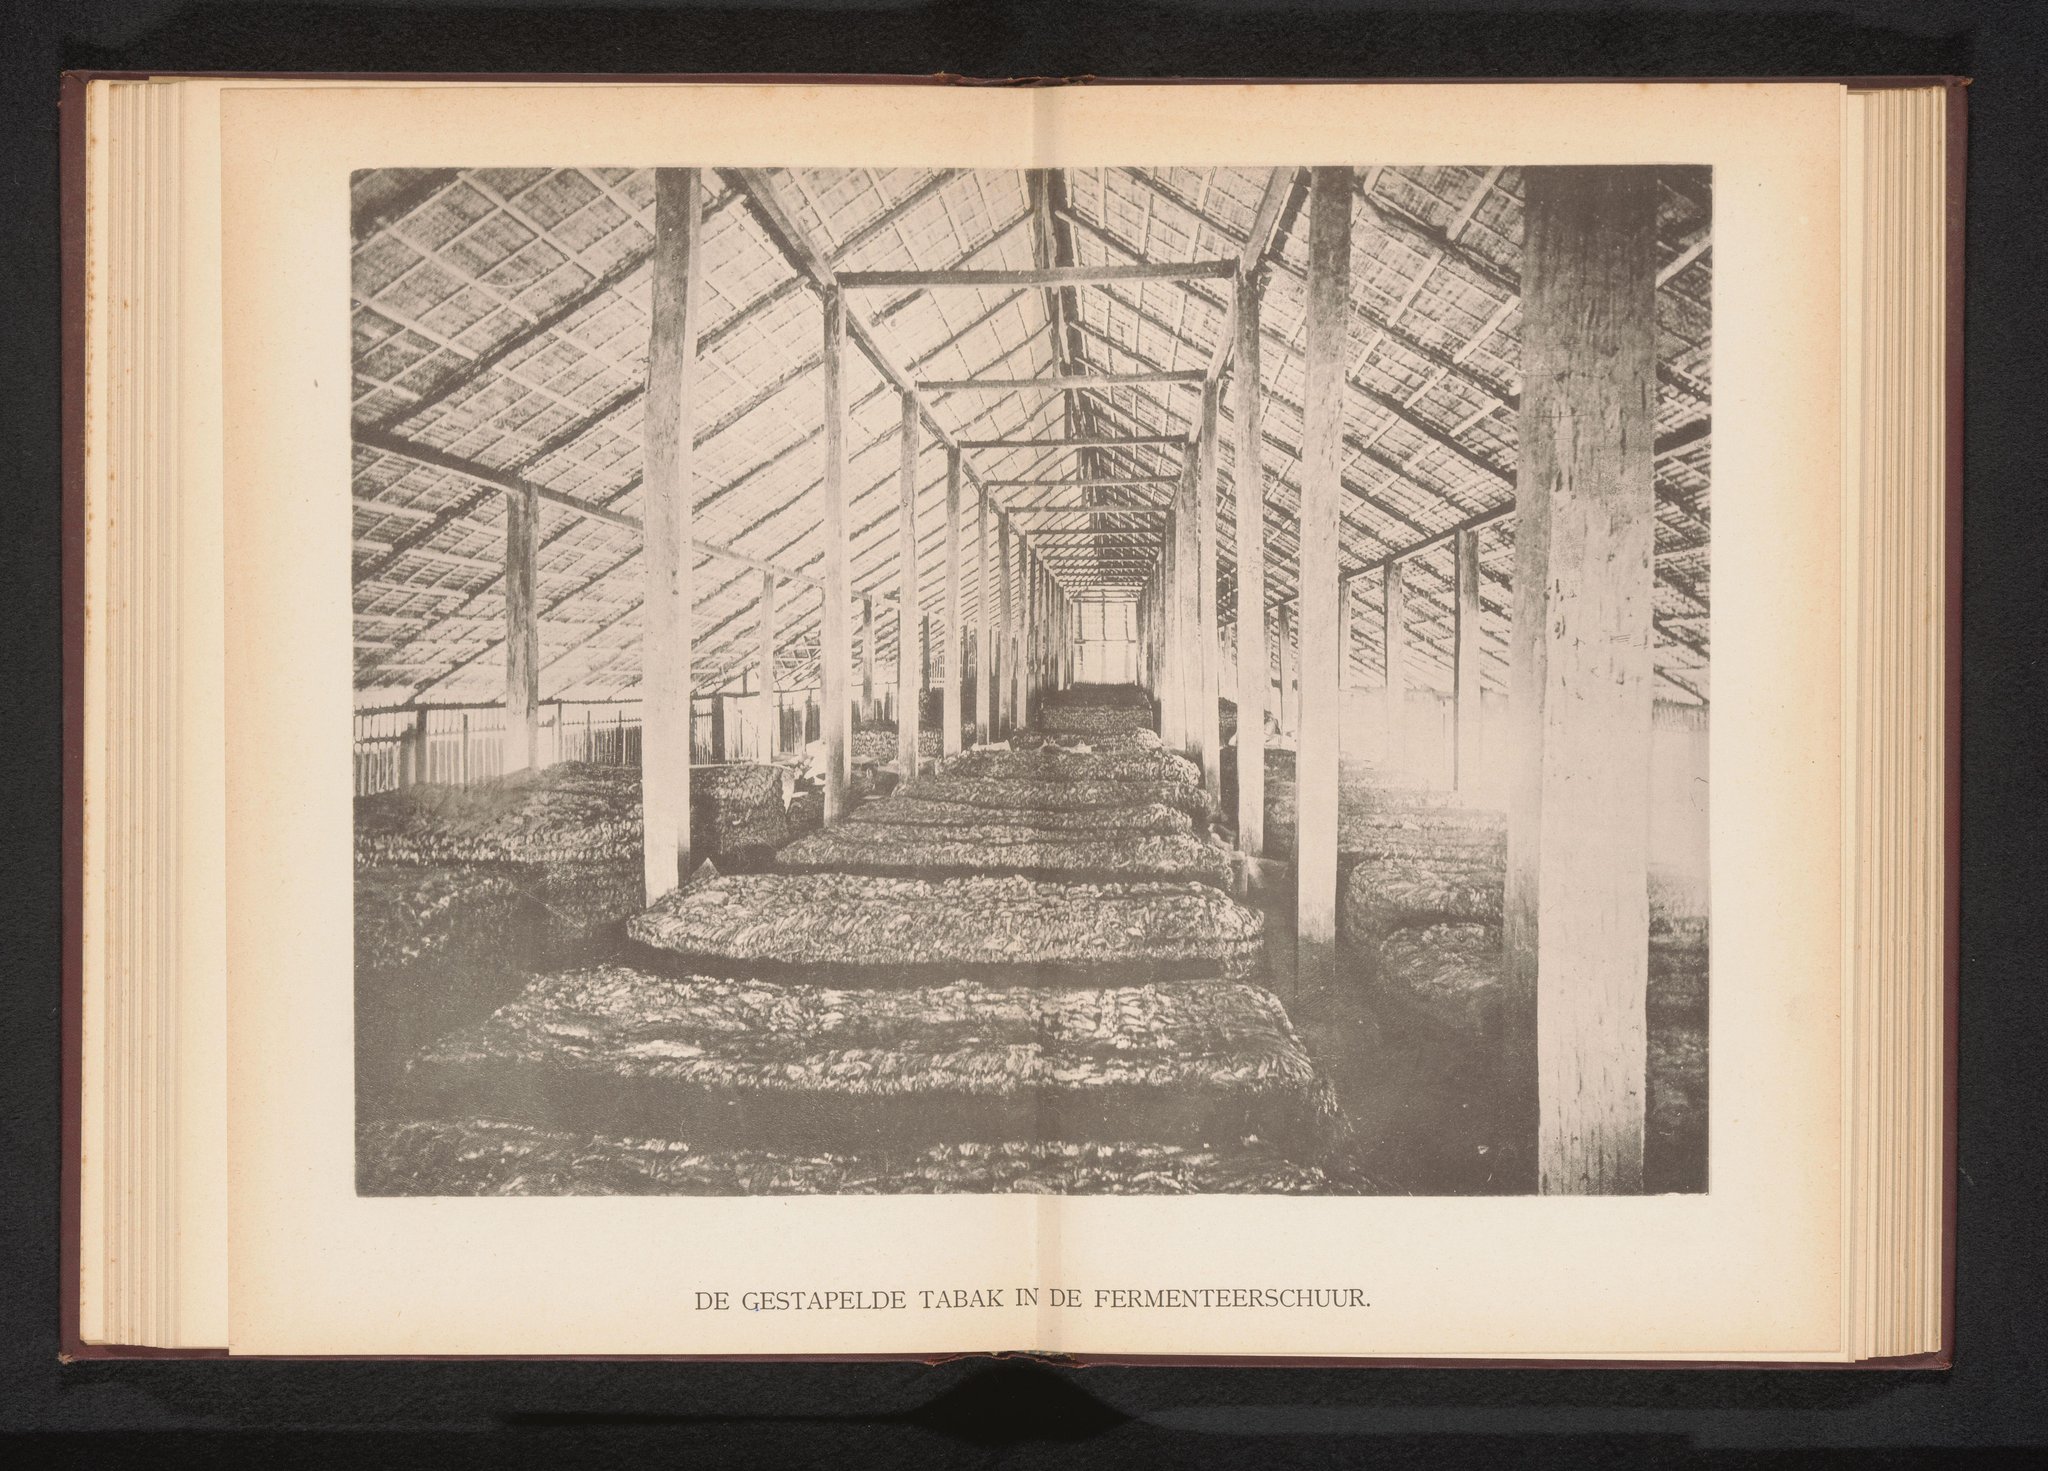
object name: photomechanical print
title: Tabak in een fermenteerschuur op een tabaksplantage in Deli, Sumatra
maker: Anonymous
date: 1884-1889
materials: paper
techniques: photograph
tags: large-scale structure for storage, e.g.: warehouse, depot, silo, plantation, additional stages: putrefaction (fermentation), tobacco, sumatra